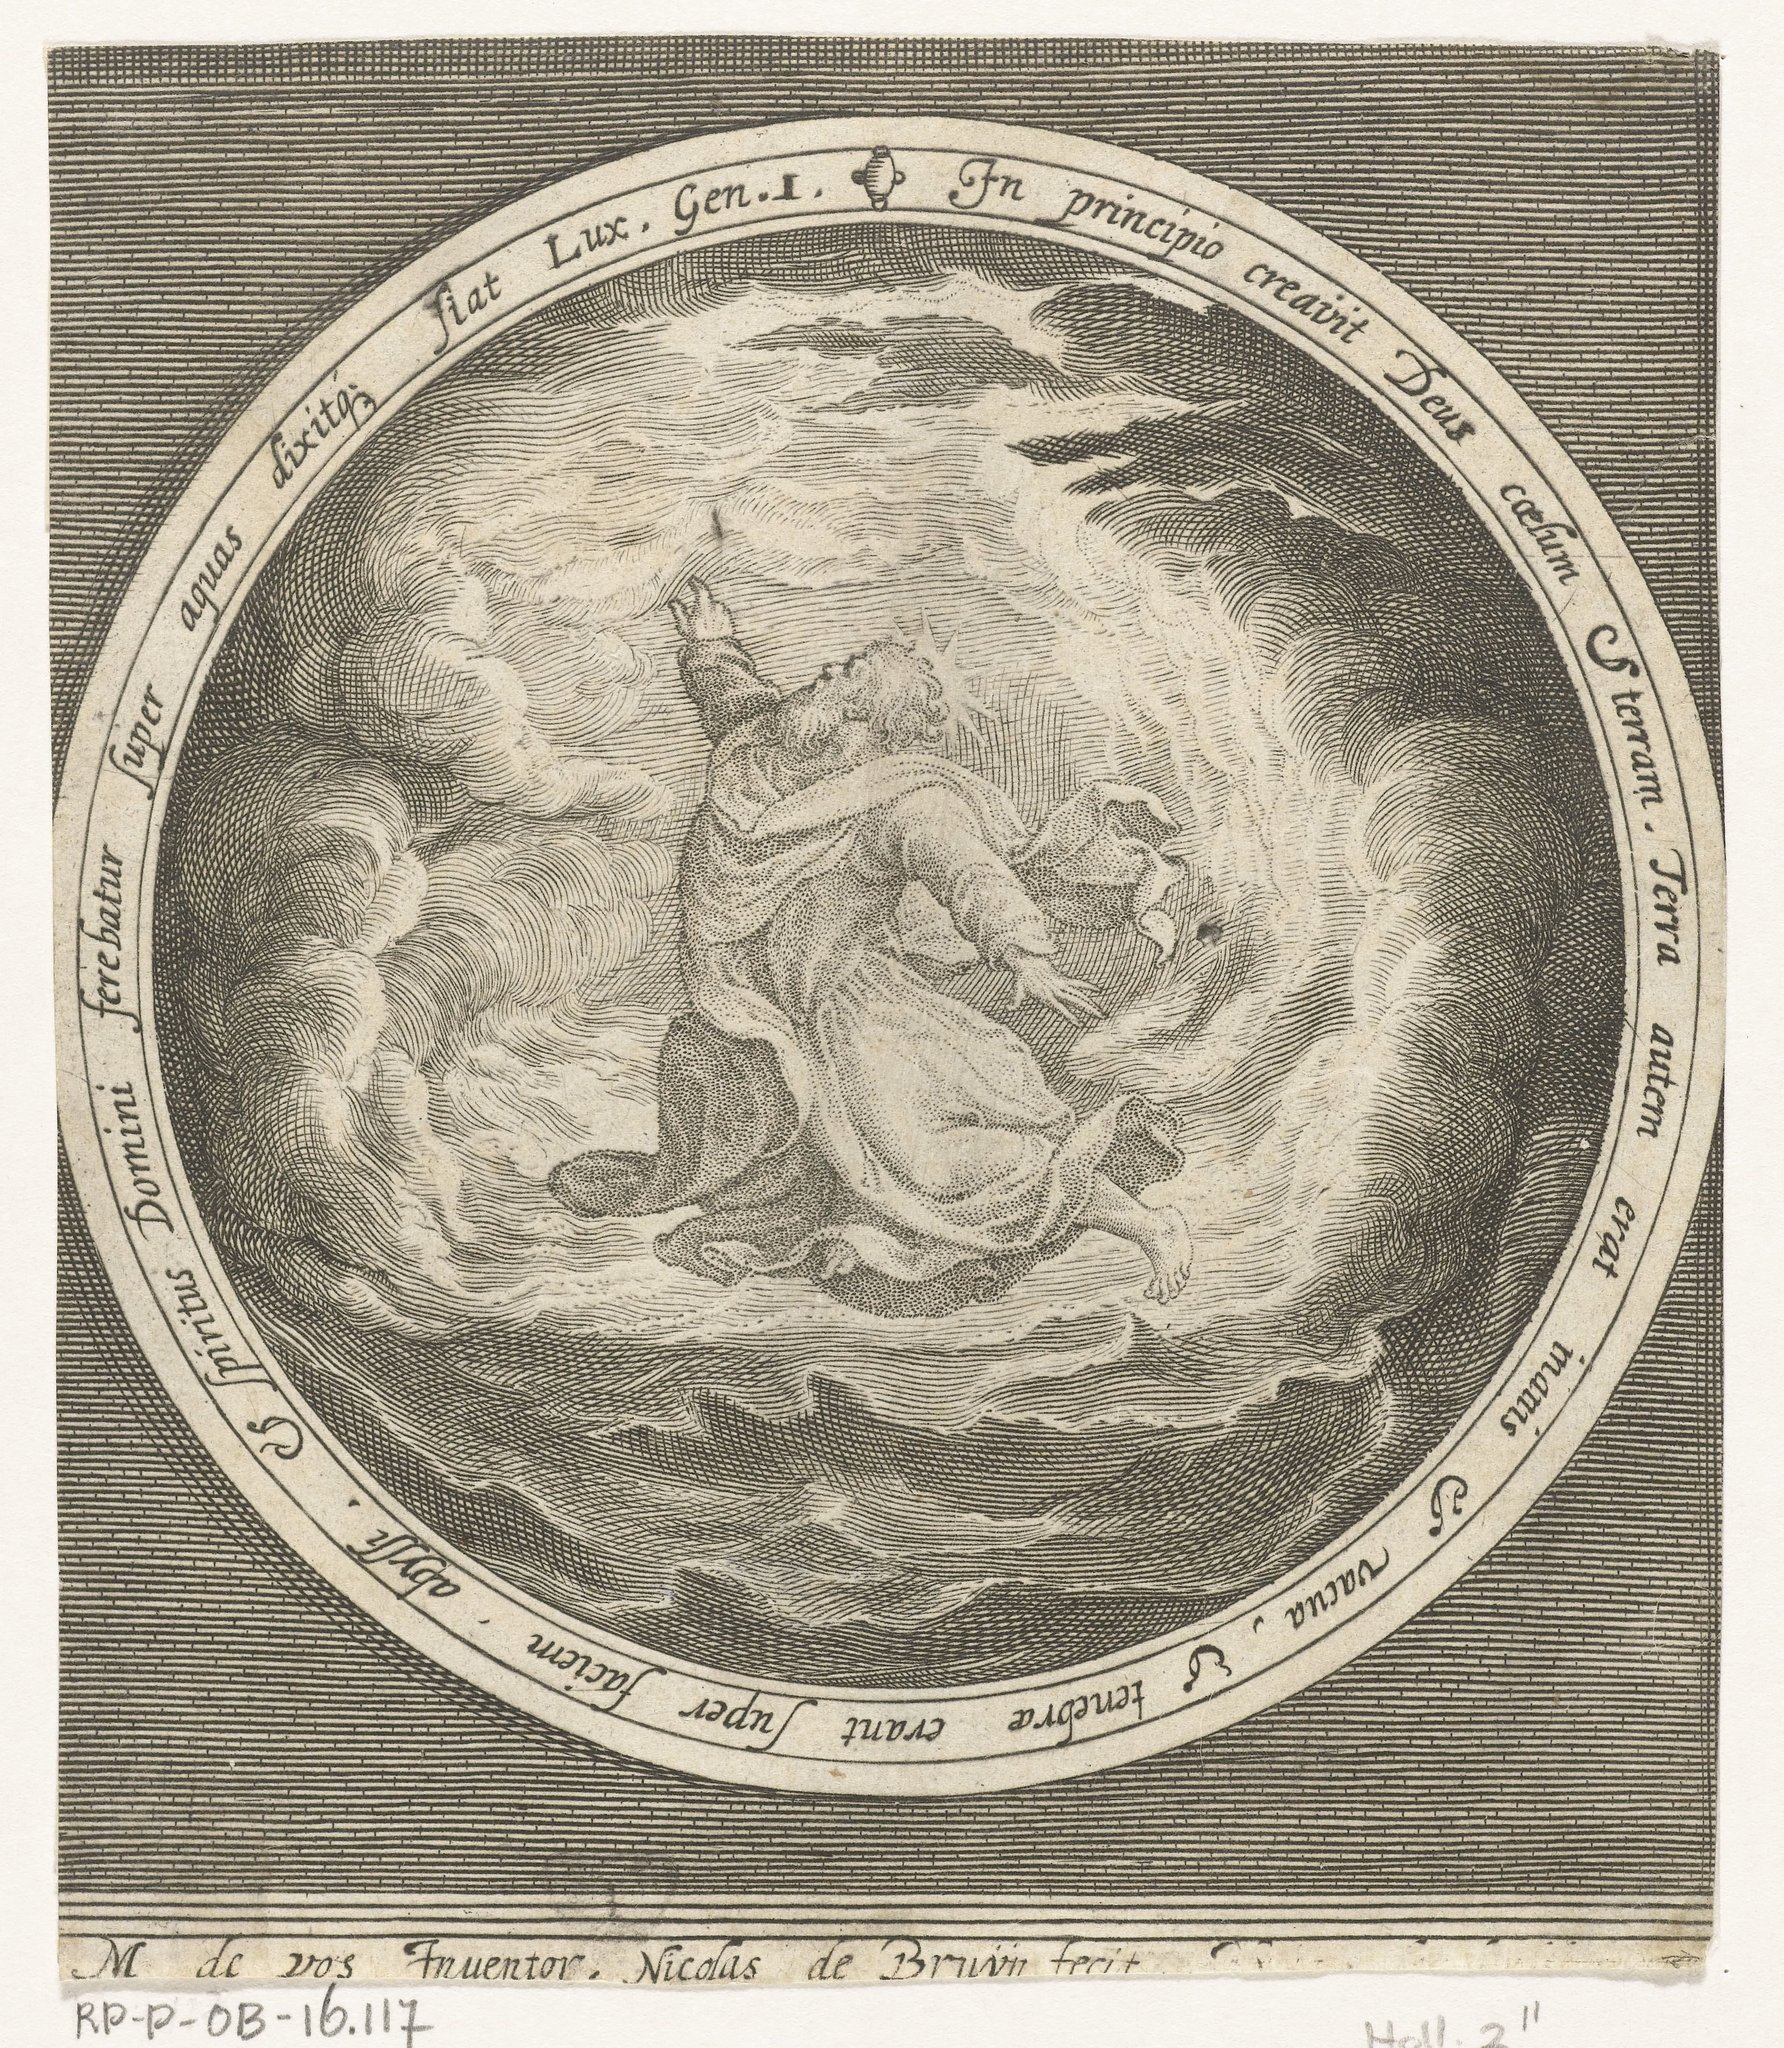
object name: print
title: Van schepping tot verdrijving uit paradijs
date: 1581-1656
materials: paper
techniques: engraving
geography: netherlands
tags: division of light and darkness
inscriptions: collector's mark: Lugt 2228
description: Eerste dag van schepping: God schept hemel en aarde. In medaillon met als opschrift een bijbeltekst in Latijn uit Genesis 1, binnen rechthoekige omlijsting.